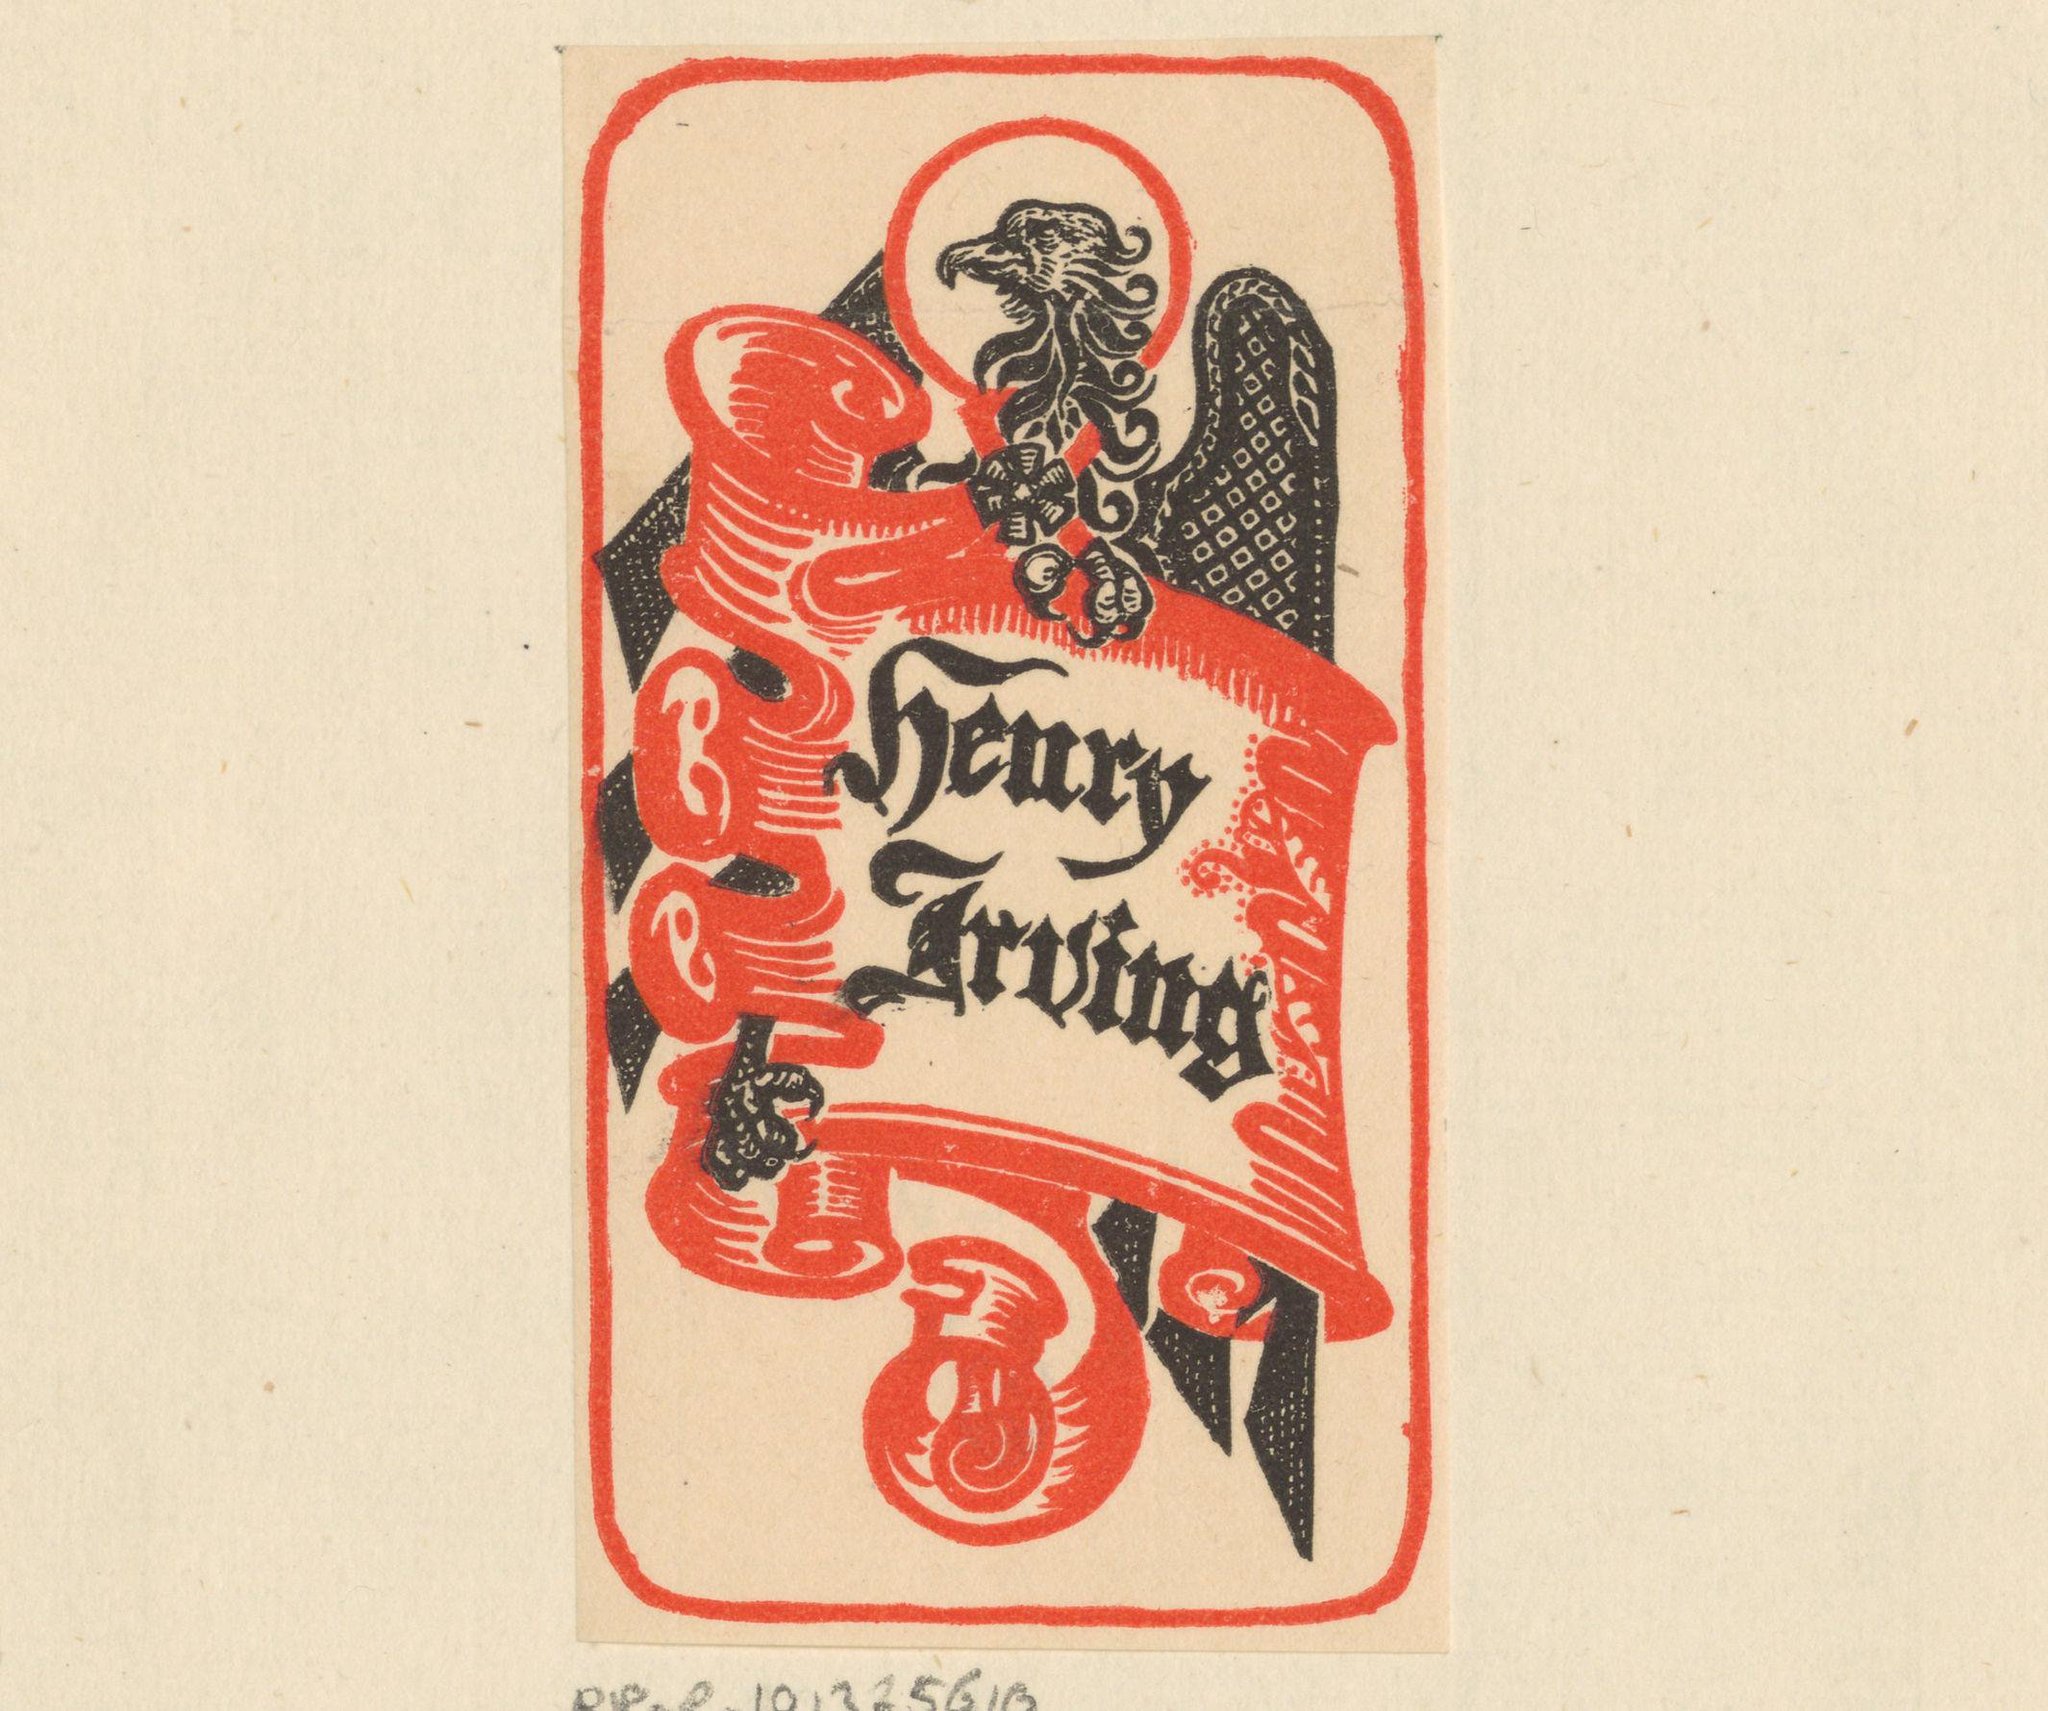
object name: bookplate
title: Ex libris van Henry Irving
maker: Anonymous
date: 1861-1913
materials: paper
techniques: printing block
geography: england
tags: predatory birds: eagle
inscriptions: collector's mark: Lugt 2233, collector's mark: Lugt 2760